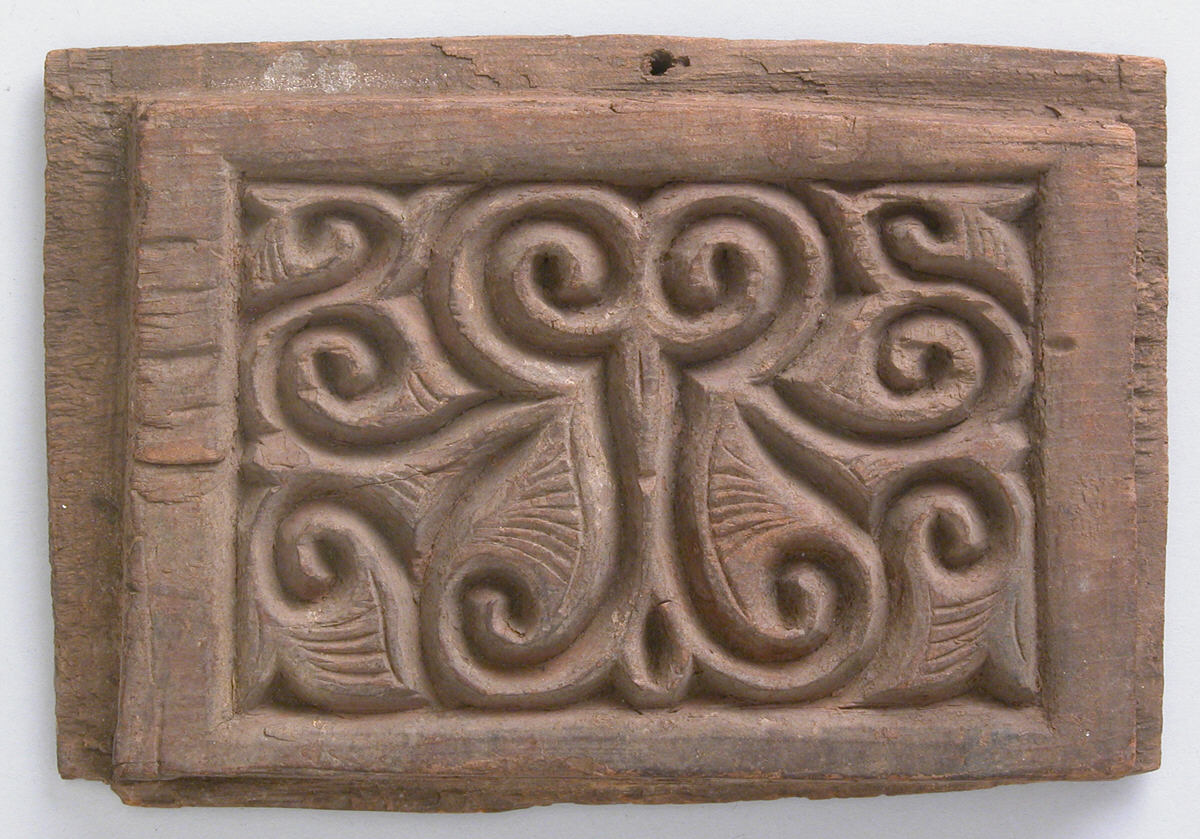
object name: panel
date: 901-1100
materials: wood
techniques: carving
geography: egypt